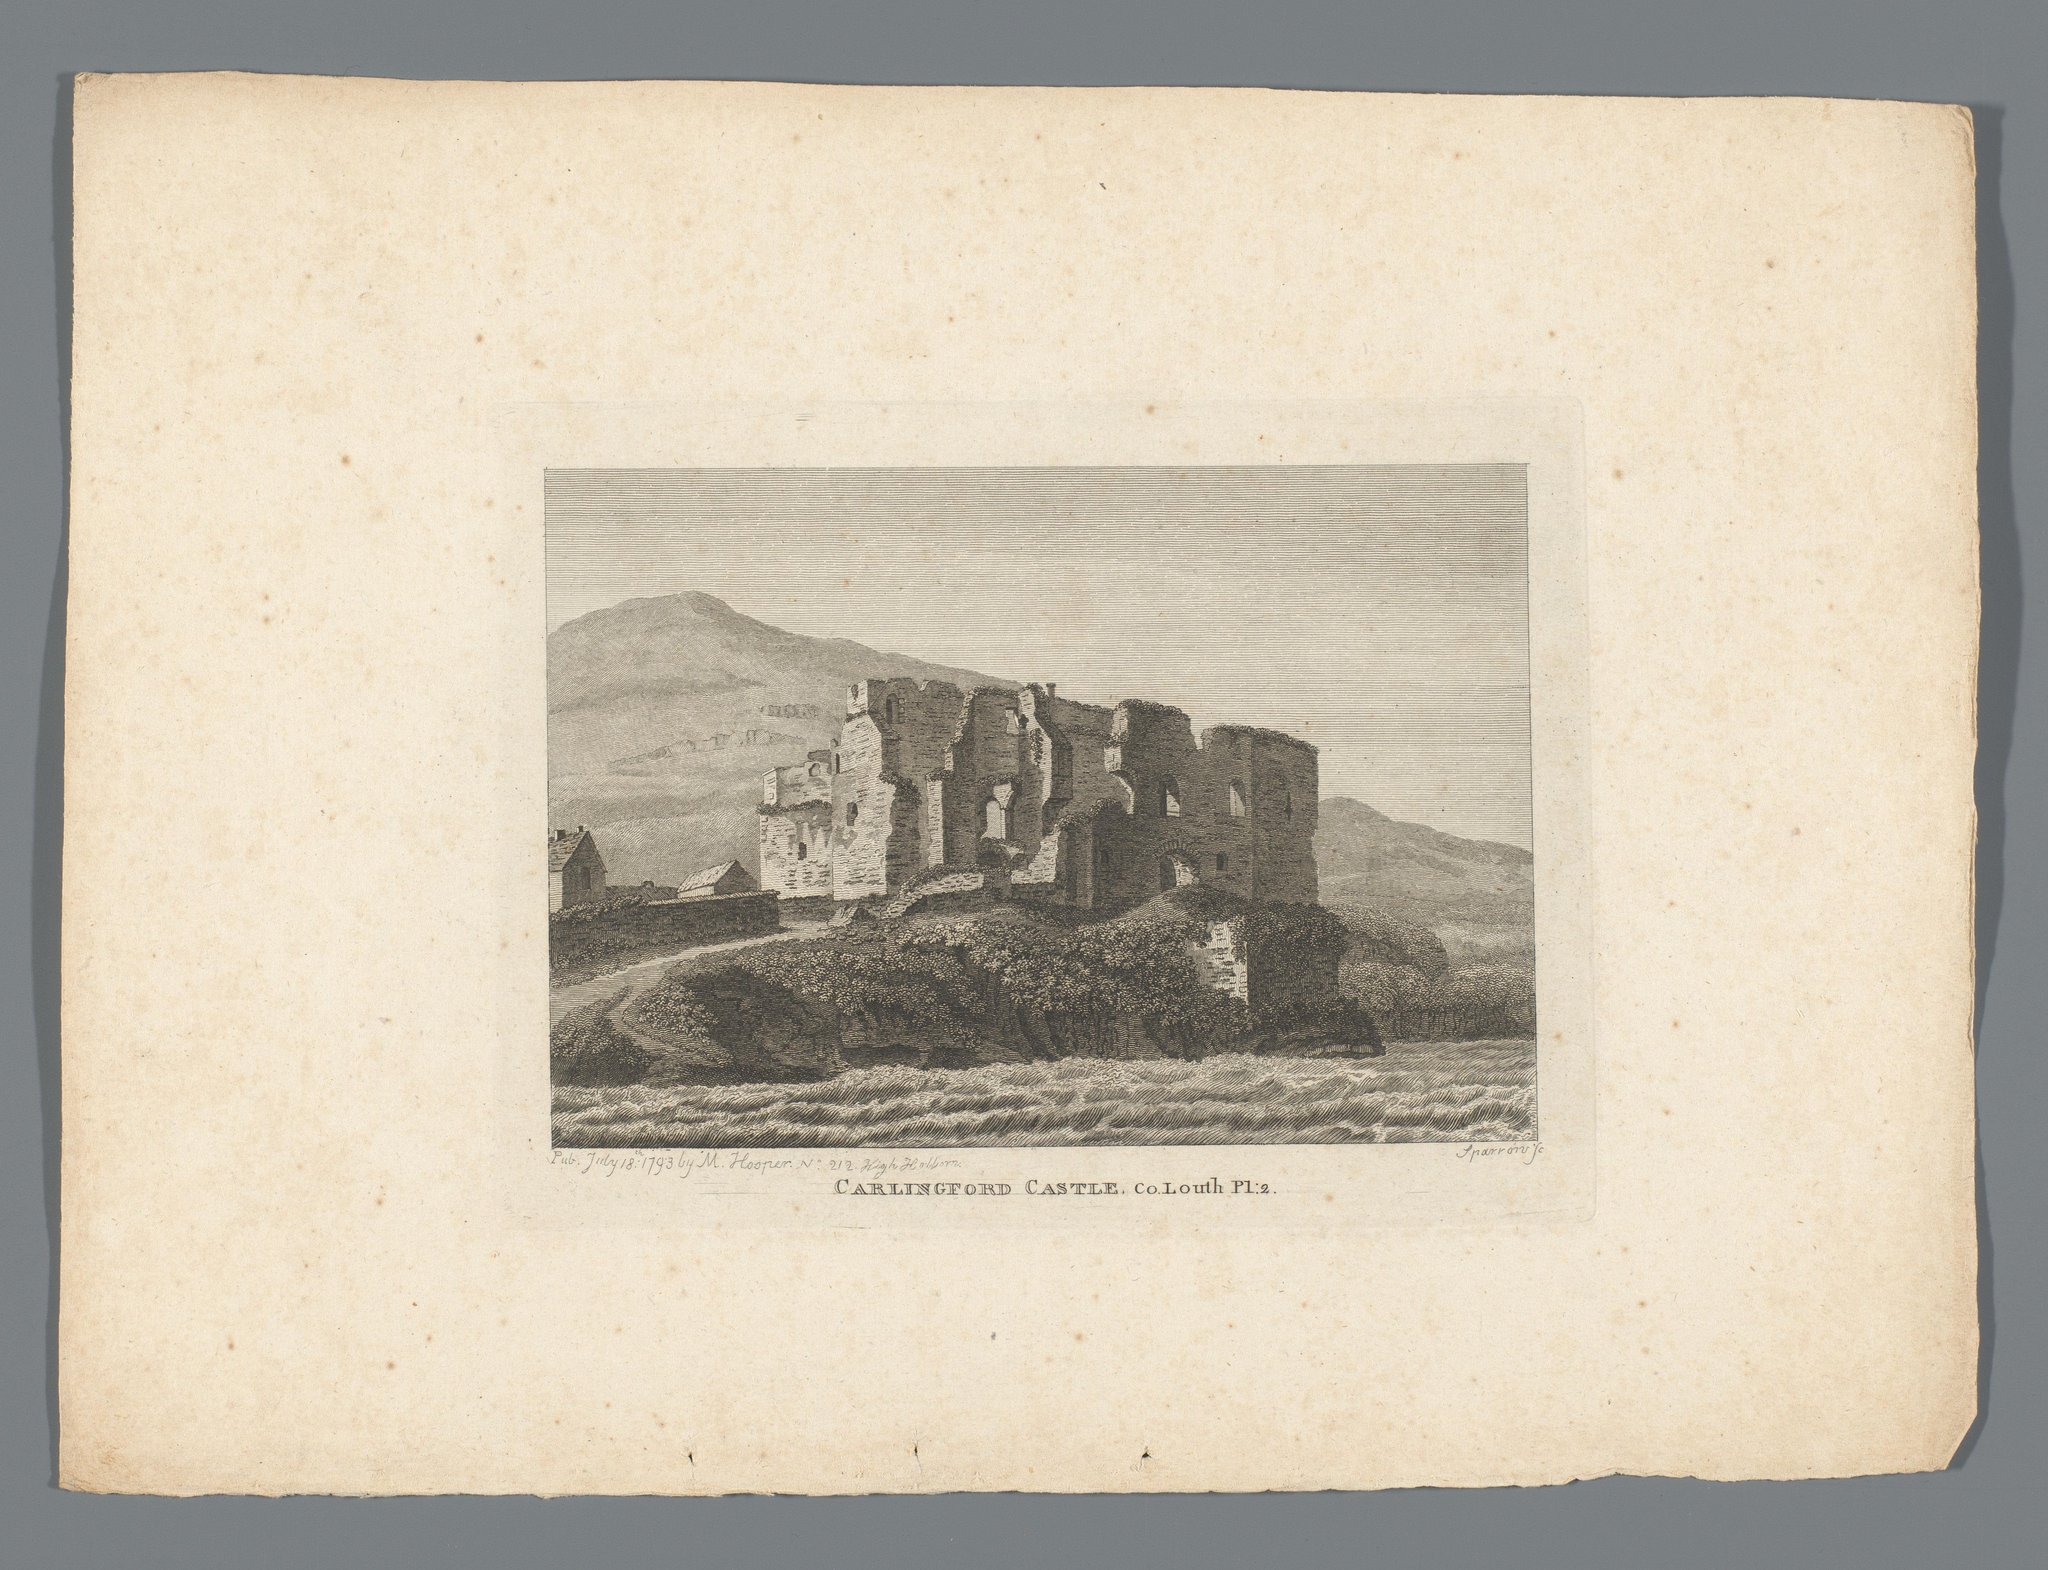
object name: print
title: Gezicht op de ruïnes van kasteel Carlingford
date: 1793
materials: paper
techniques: etching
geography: london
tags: landscape with ruins, landscape with tower or castle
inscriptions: date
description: Prent verschenen in: Grose, Francis. The antiquities of Ireland, dl. 2. Londen: S. Hooper, 1795.